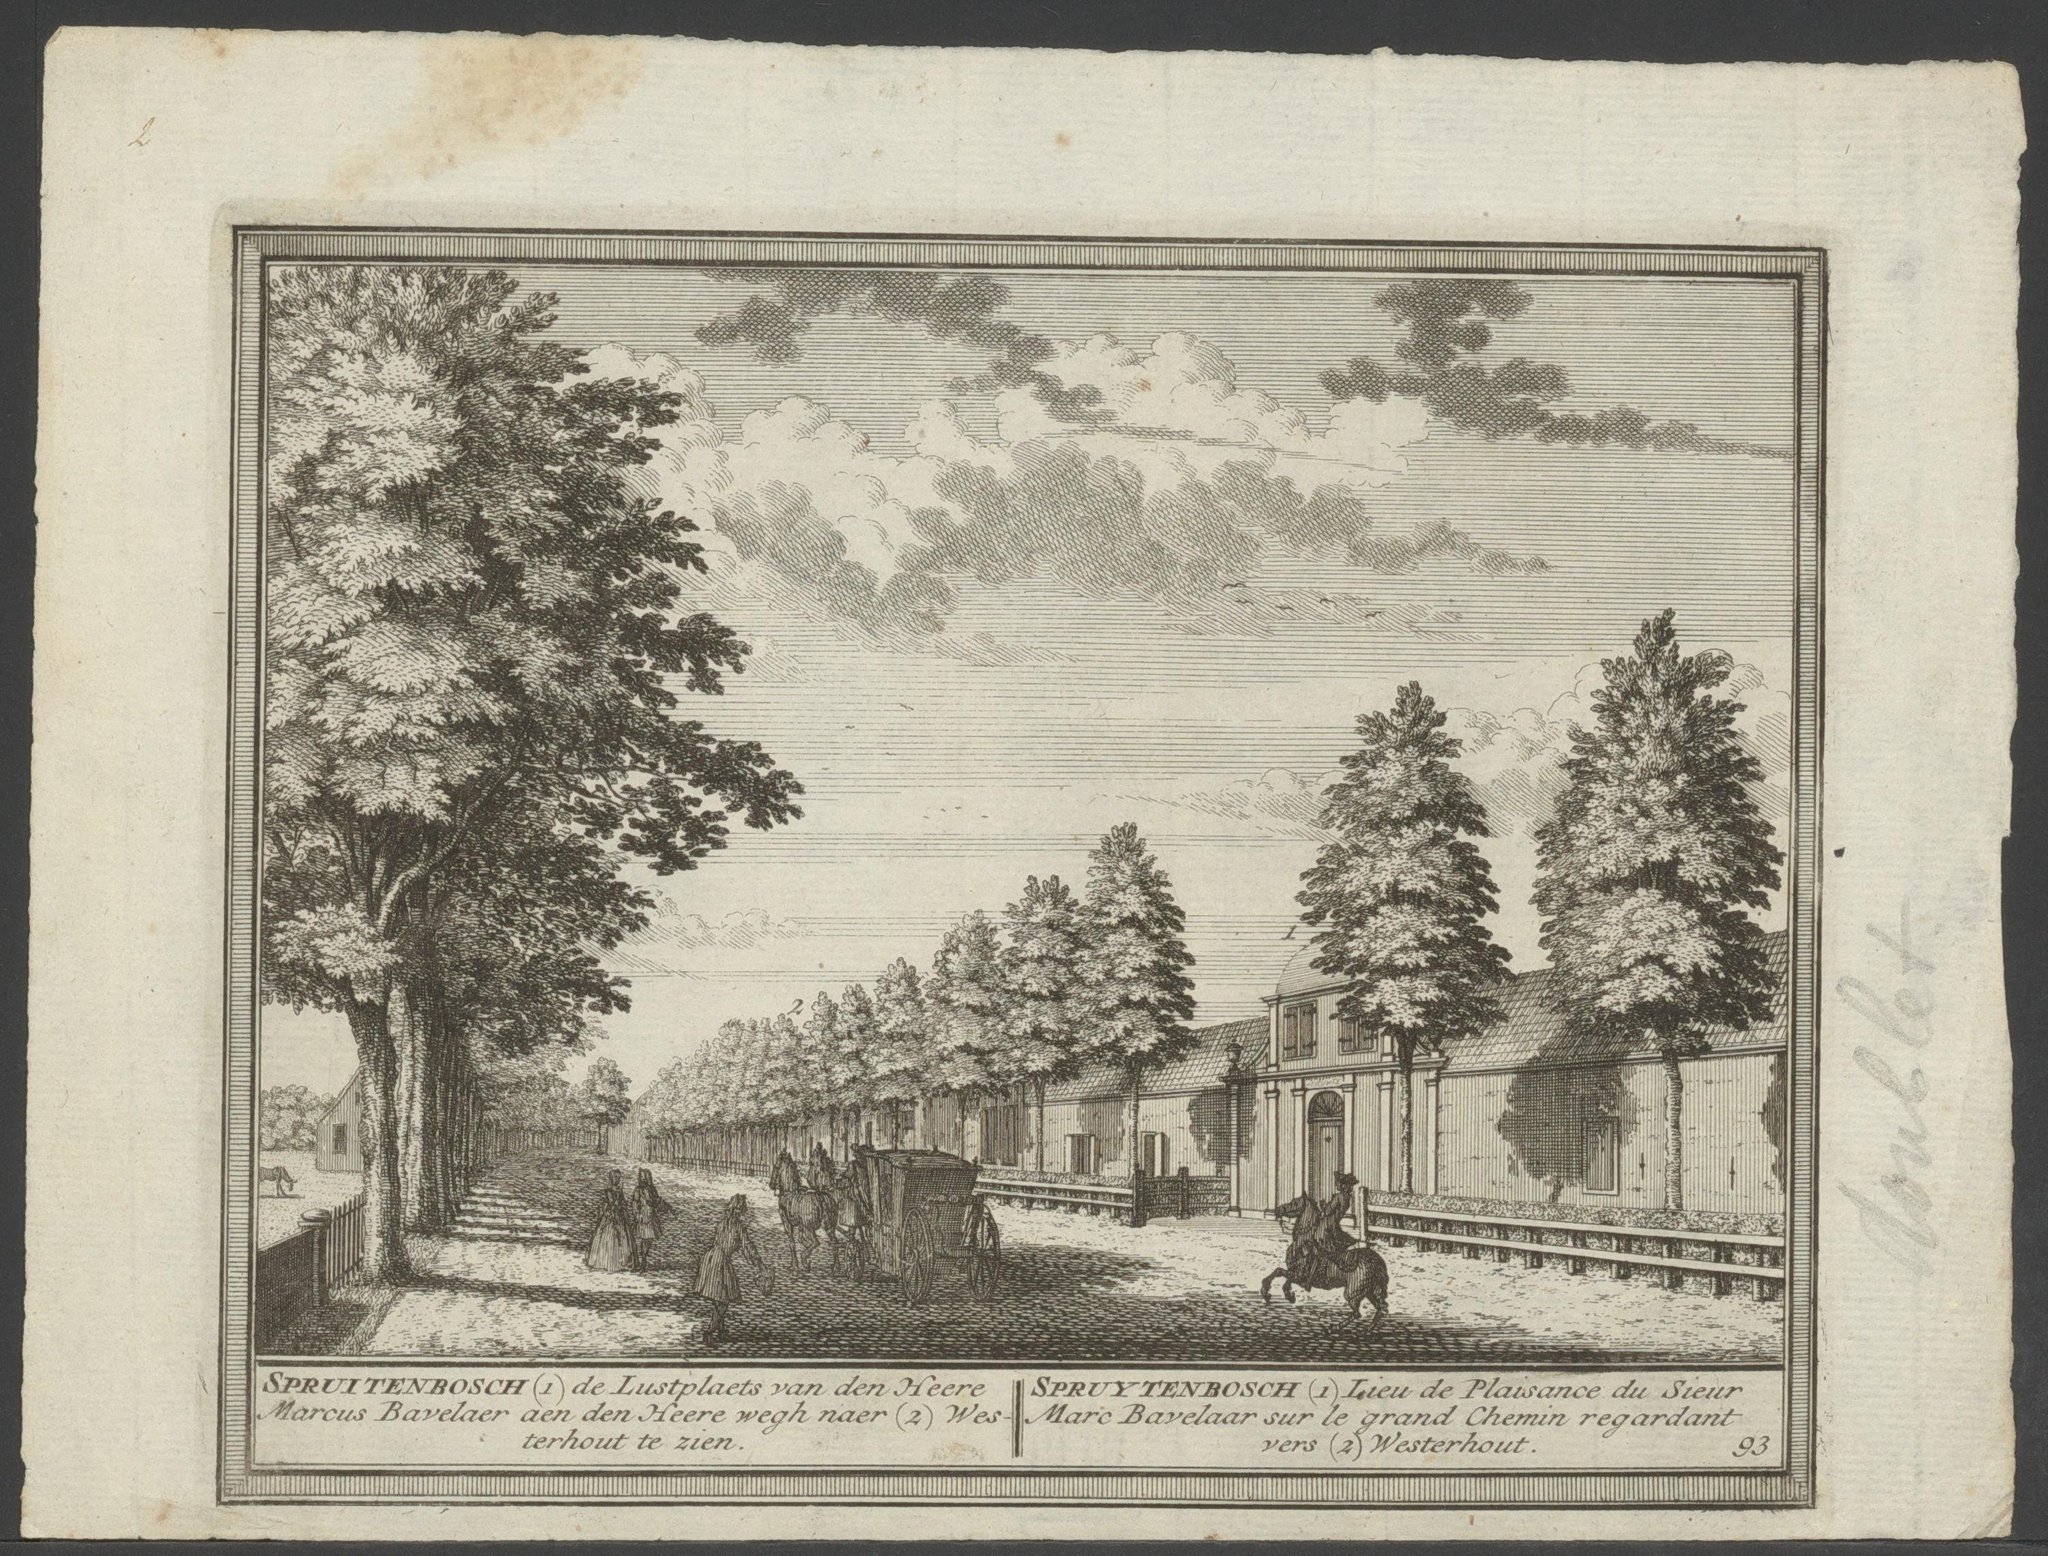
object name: print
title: Gezicht op het Spaarne vanaf lustplaats Spaar en Hout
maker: hendrik de leth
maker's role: draughtsman, print maker, publisher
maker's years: 1703-1766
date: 1732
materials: paper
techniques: engraving, etching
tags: trees, lane, alley, haarlem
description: Prent waarschijnlijk uit: Broüerius van Nidek, Mattheus. Het Zegenpralent Kennemerlant, vertoont in veele Heerlijke Gezichten. Amsterdam: Leth, Hendrik de en Leth, Andries de, 1729, dl. 2. Of uit: Broüerius van Nidek, Mattheus. Het Zegenpralent Kennemerlant, vertoont in veele Heerlijke Gezichten. Amsterdam: Leth, Hendrik de en Leth, Andries de, 1732, dl. 2.